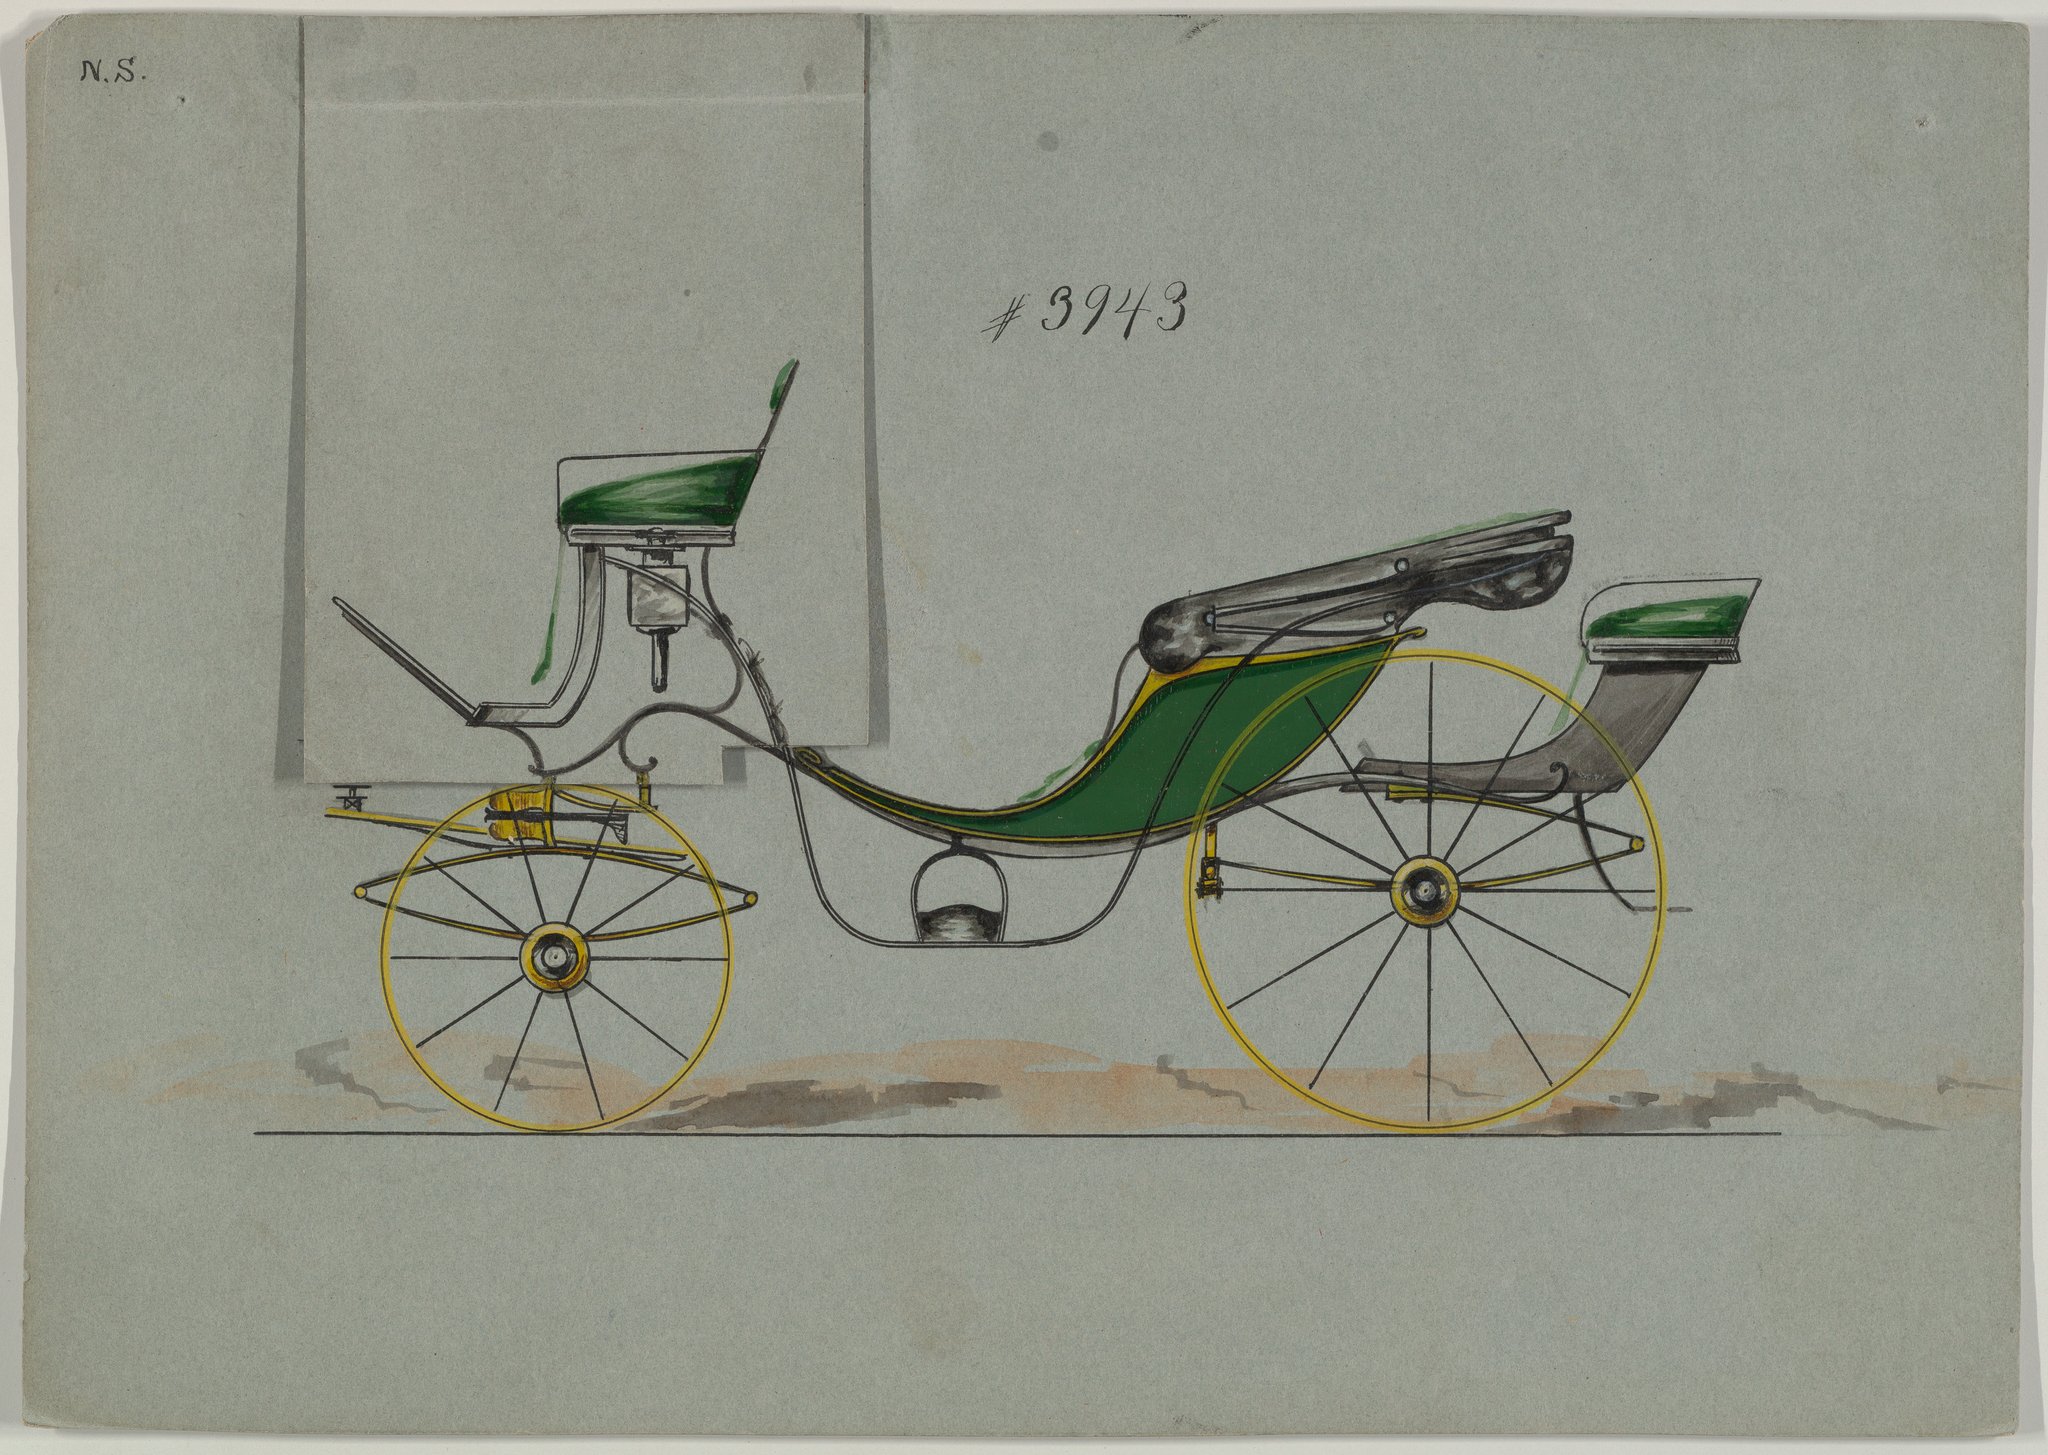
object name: drawing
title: Design for Cabriolet or Victoria, no. 3943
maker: brewster & co.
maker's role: manufacturer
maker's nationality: american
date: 1883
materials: gouache, gum arabic, ink, watercolor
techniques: pen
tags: carriages